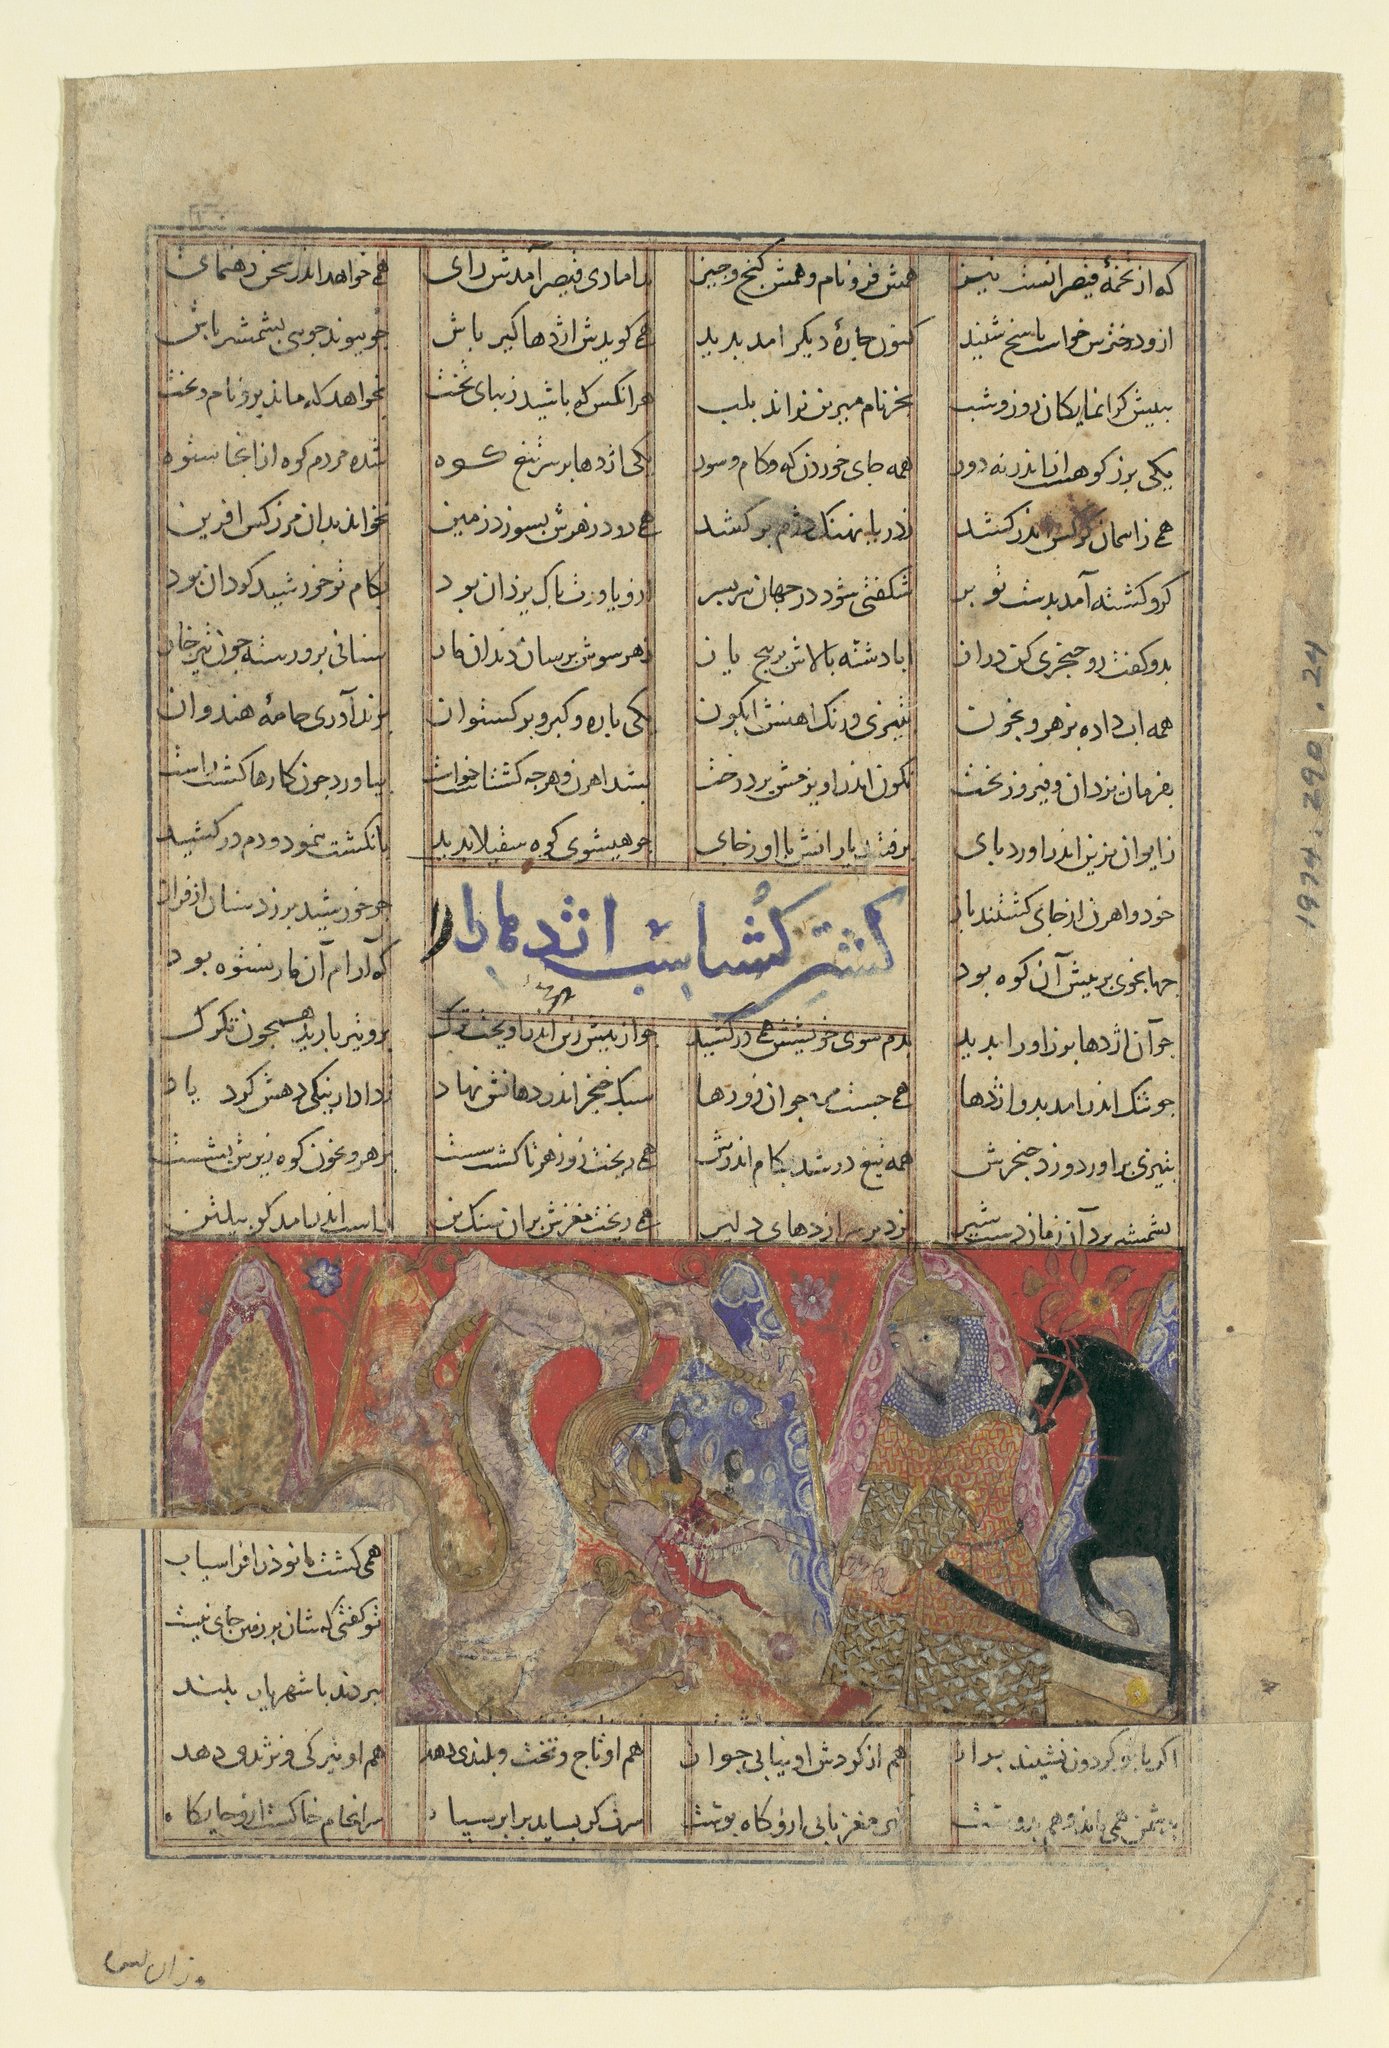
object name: folio from an illustrated manuscript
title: "Gushtasp Slays the Dragon of Mount Saqila", Folio from a Shahnama (Book of Kings) of Firdausi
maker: abu'l qasim firdausi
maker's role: author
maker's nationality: iranian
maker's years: 935-1020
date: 1330-1340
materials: gold, ink, paper, silver, watercolor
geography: iran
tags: poetry,men,dragons,horses